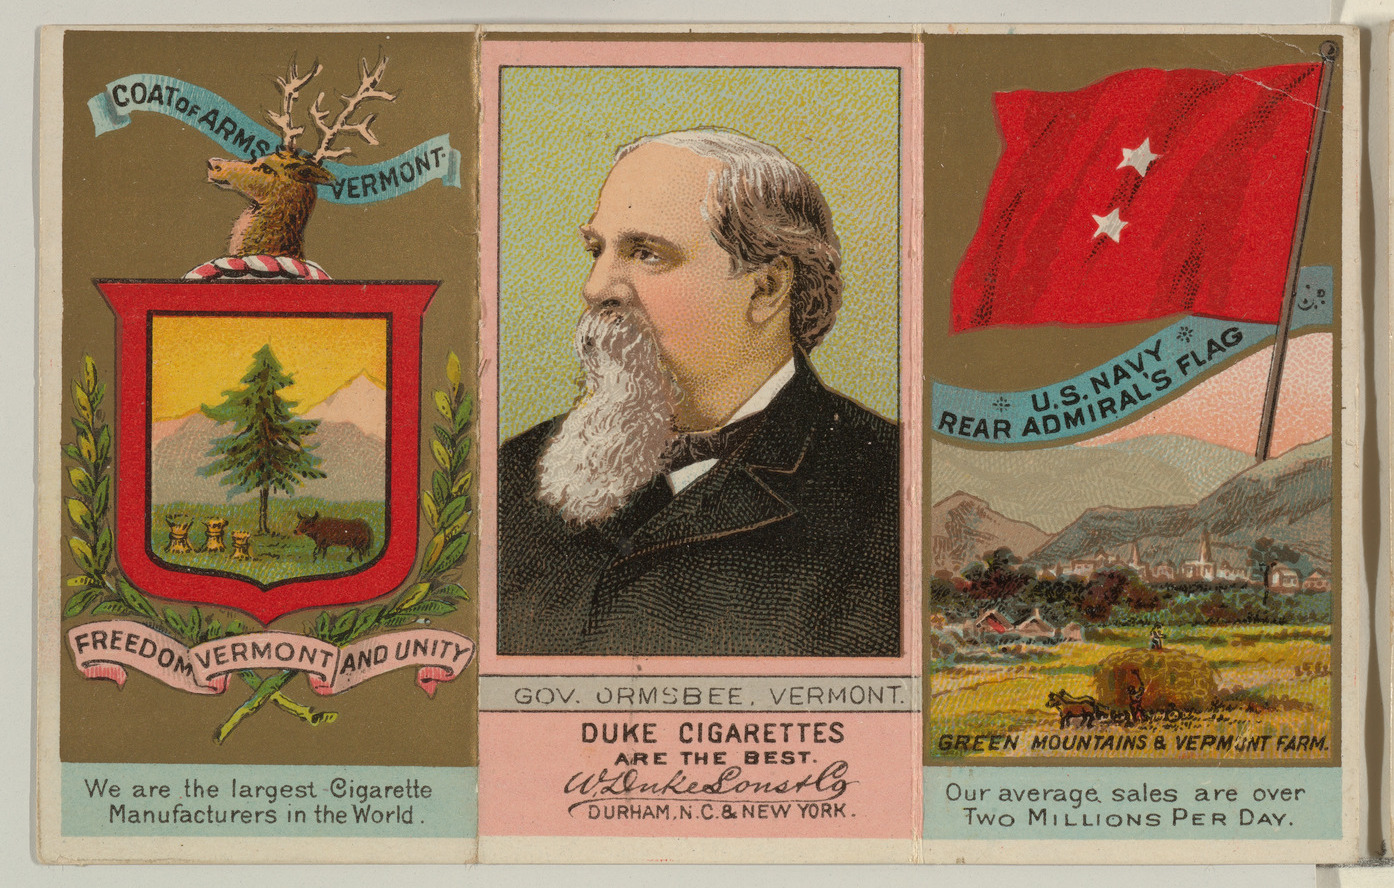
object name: print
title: Governor Ormsbee, Vermont, from "Governors, Arms, Etc." series (N133-2), issued by Duke Sons & Co.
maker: w. duke, sons & co.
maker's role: publisher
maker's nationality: american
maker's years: 1870-1920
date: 1888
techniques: color lithograph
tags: men,profiles,landscapes,coat of arms,flags